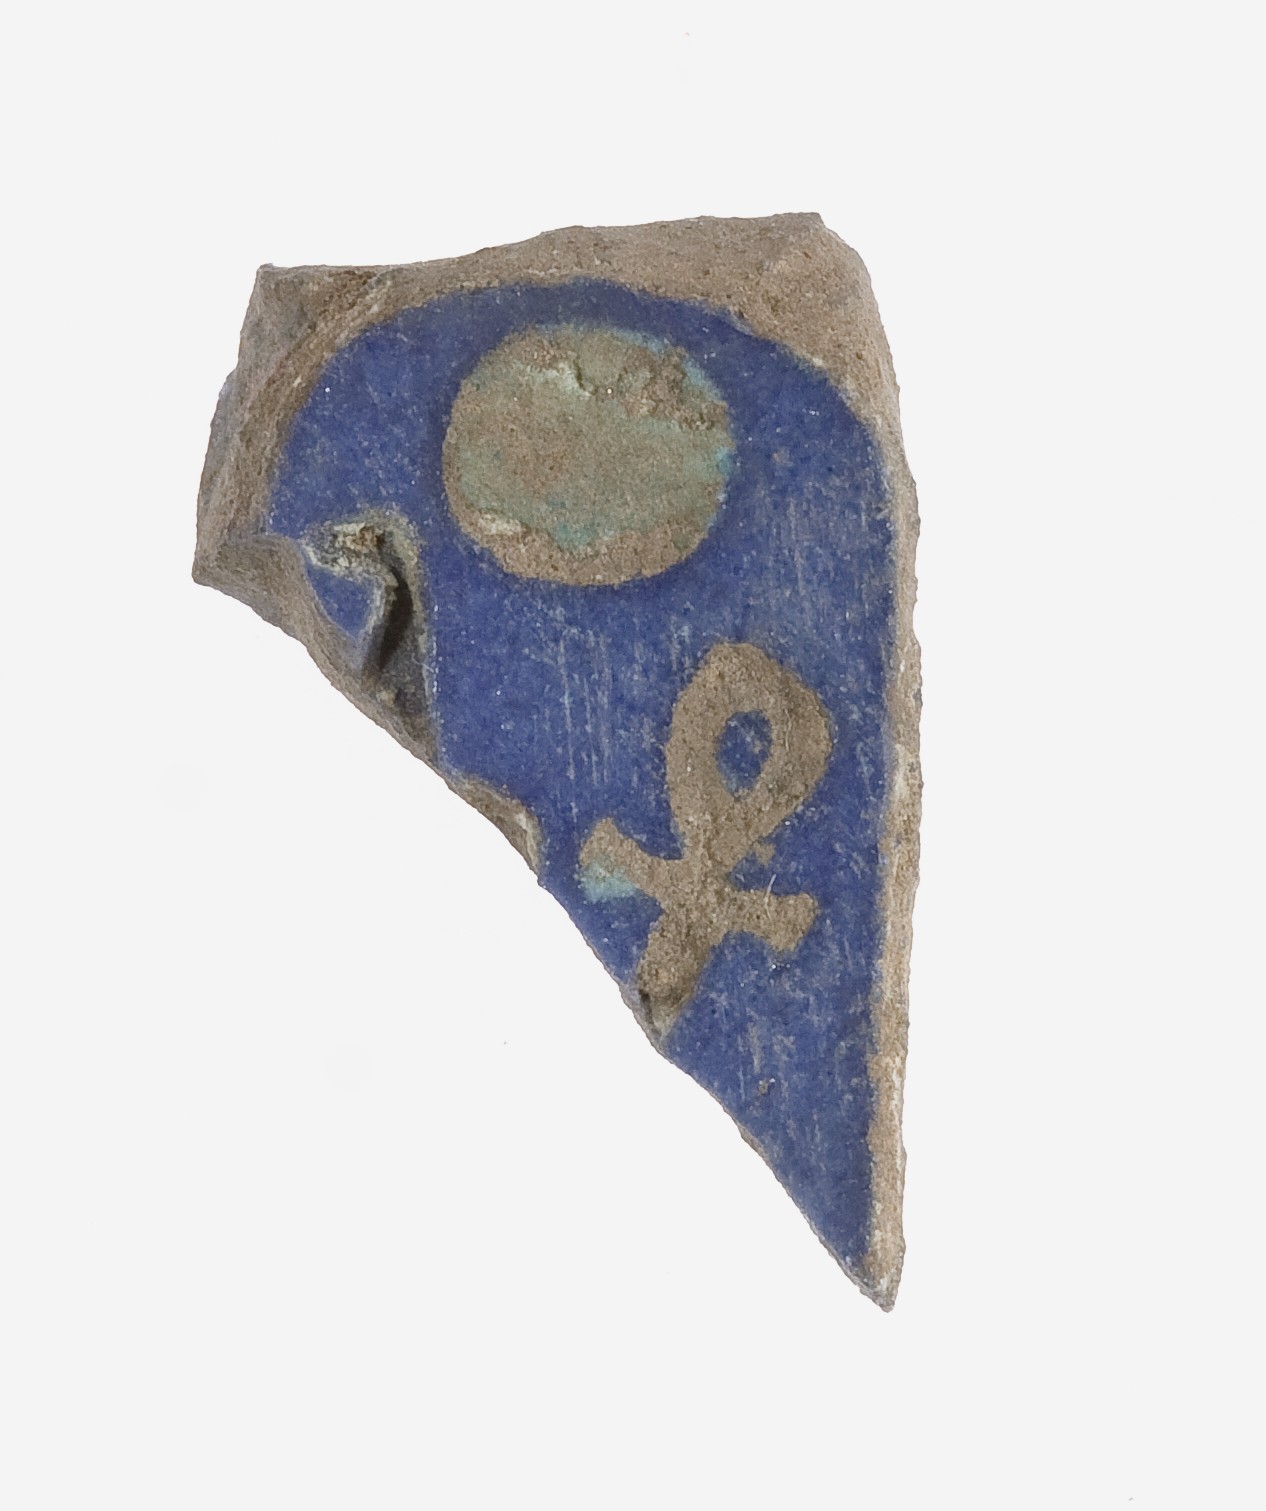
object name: vase fragment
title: Fragment of Toilet Dish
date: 1390-1352 BCE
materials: faience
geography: egypt